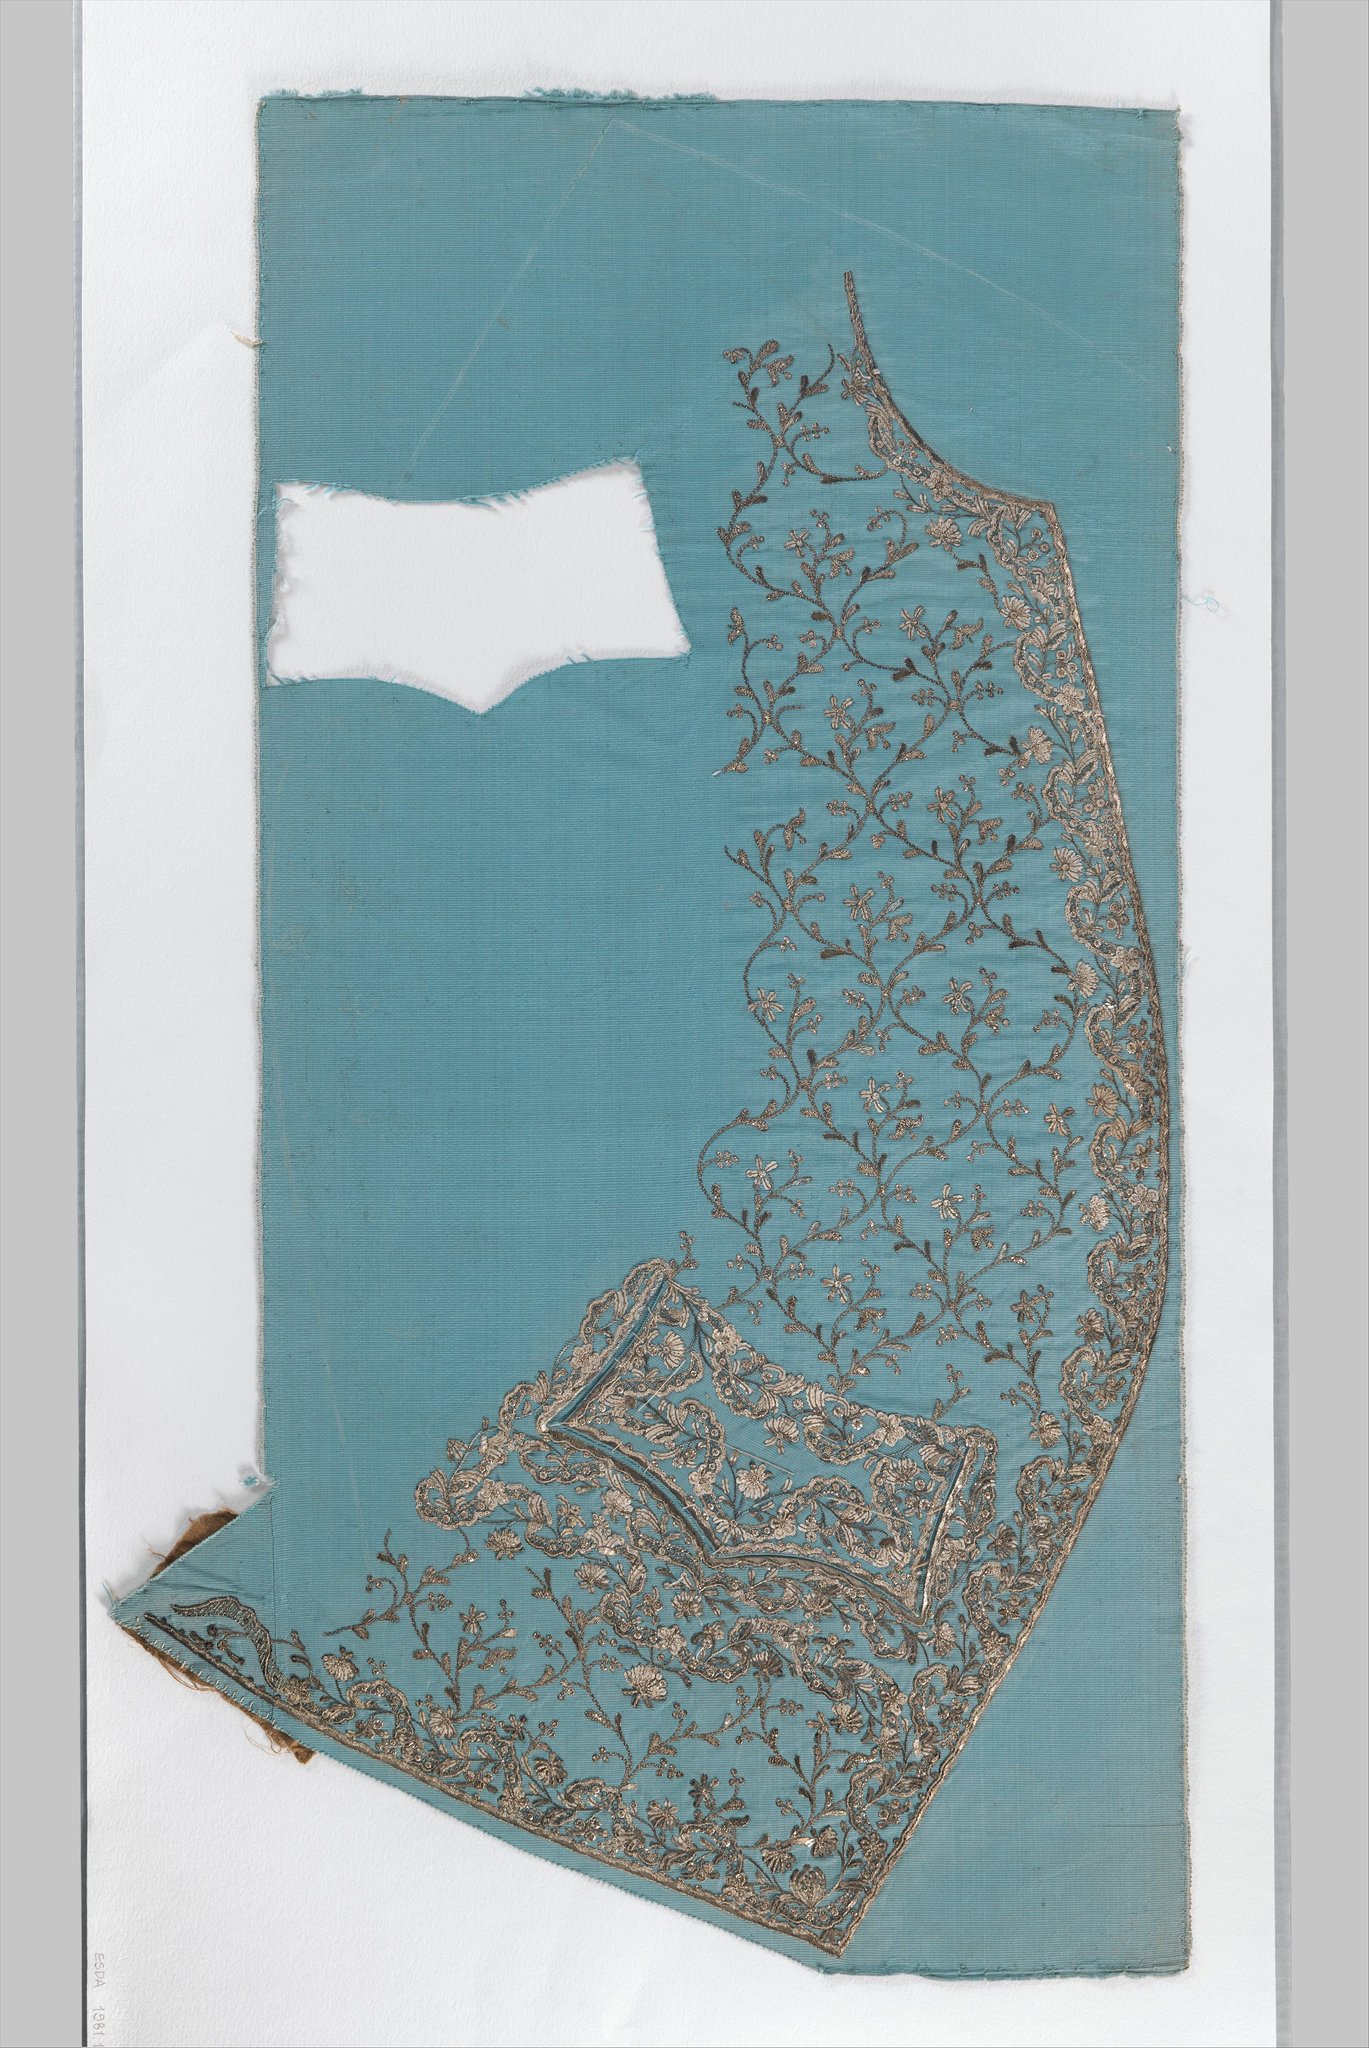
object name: waistcoat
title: Waistcoat front panels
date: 1760-1769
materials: metal thread, silk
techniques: embroidery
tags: flowers